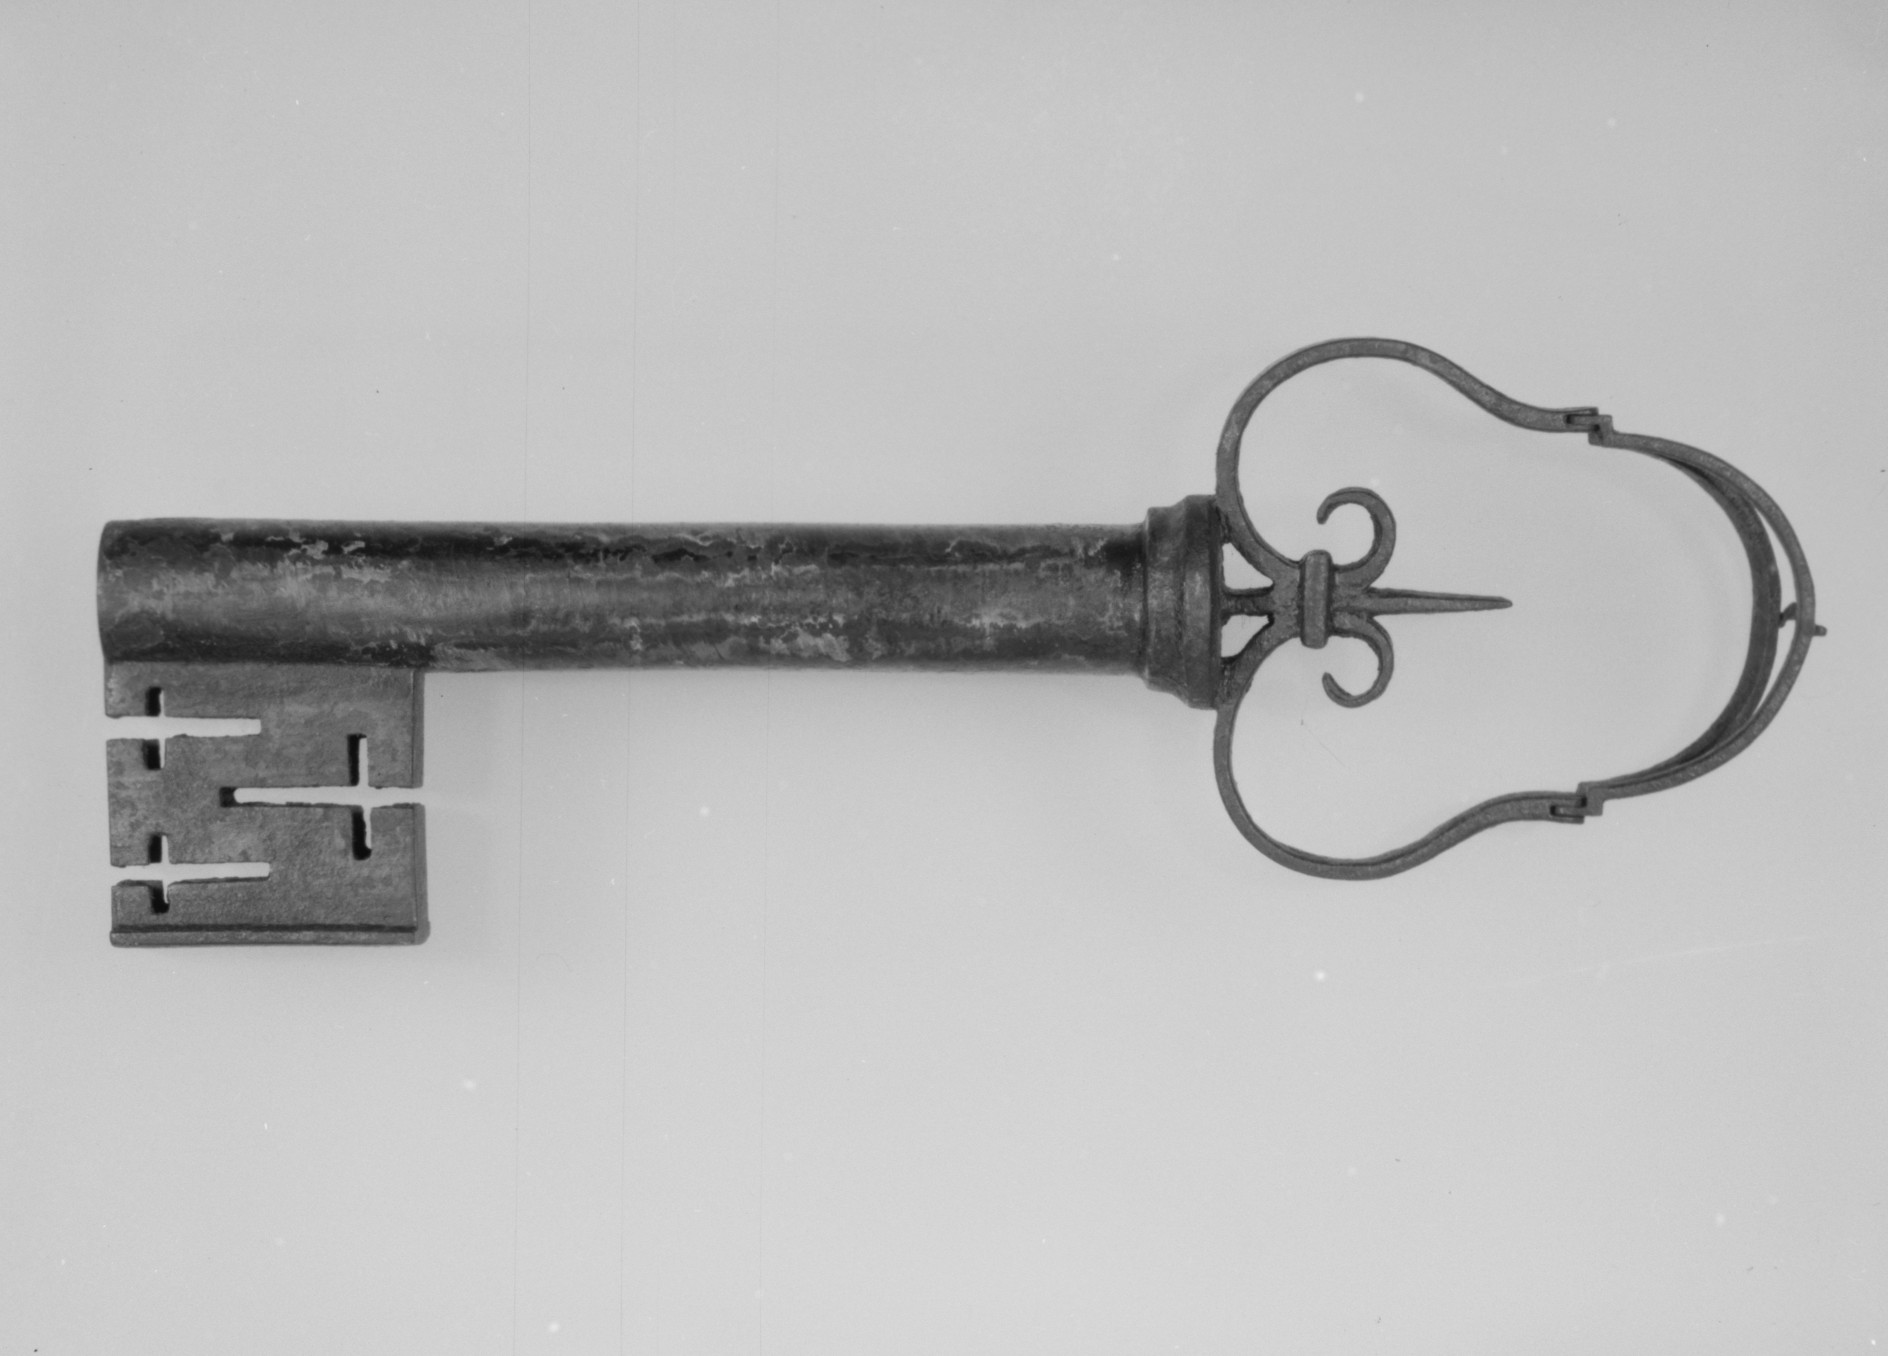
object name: shop sign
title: Shop sign in the form of a key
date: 1601-1800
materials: iron